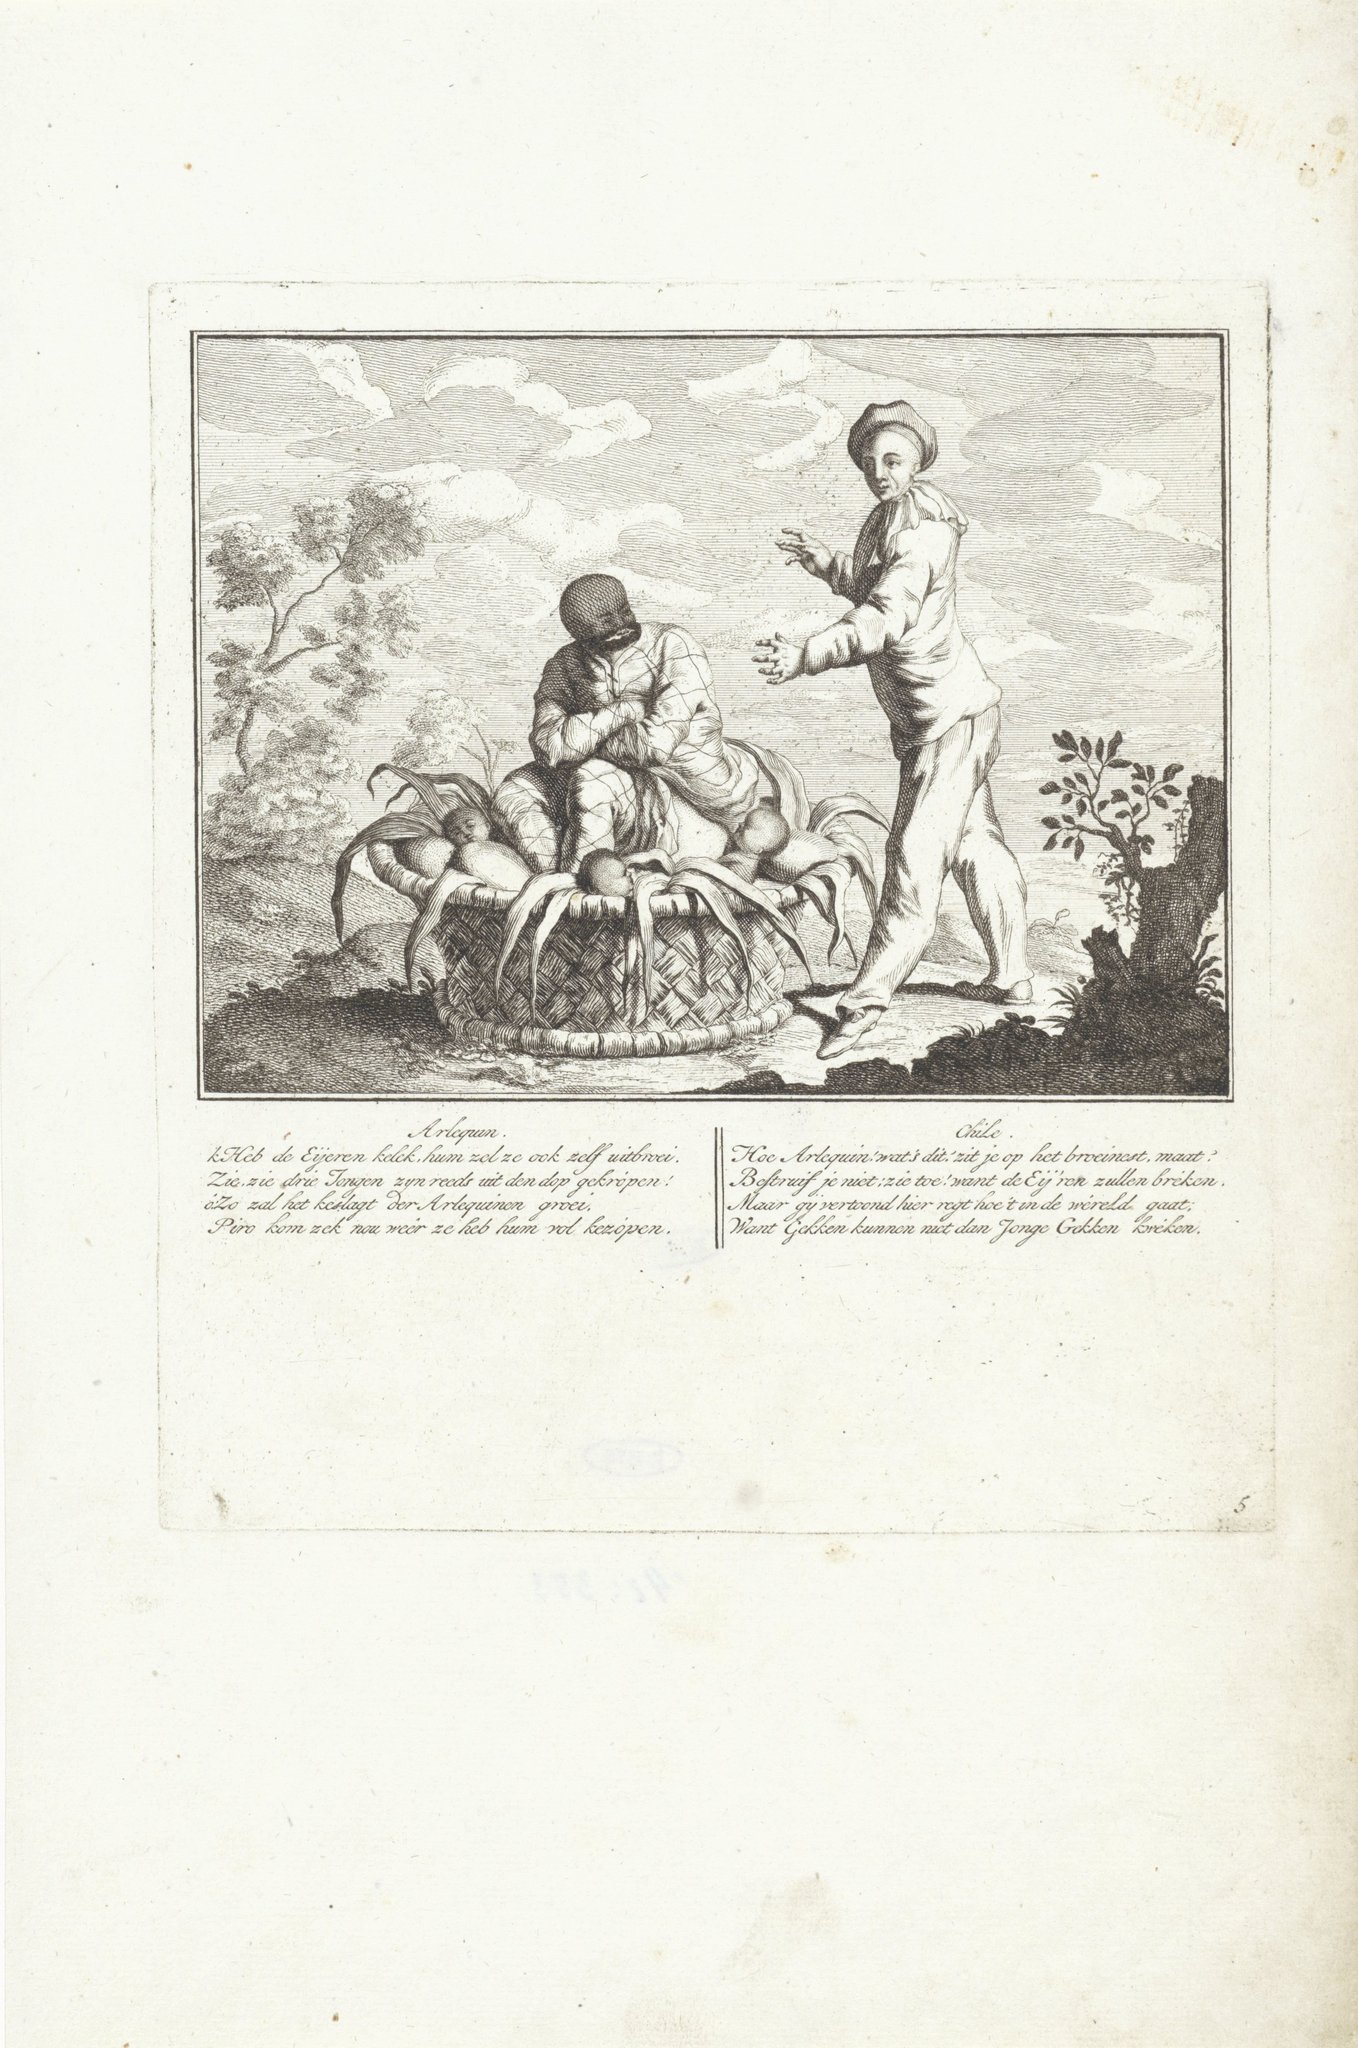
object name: print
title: Arlequin als opvoeder van de kleine Arlequin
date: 1720-1728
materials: paper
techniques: engraving, etching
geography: amsterdam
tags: types in 'commedia dell'arte', brooding, types in 'commedia dell'arte': harlequin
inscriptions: collector's mark: Lugt 2760, collector's mark: Lugt 2228